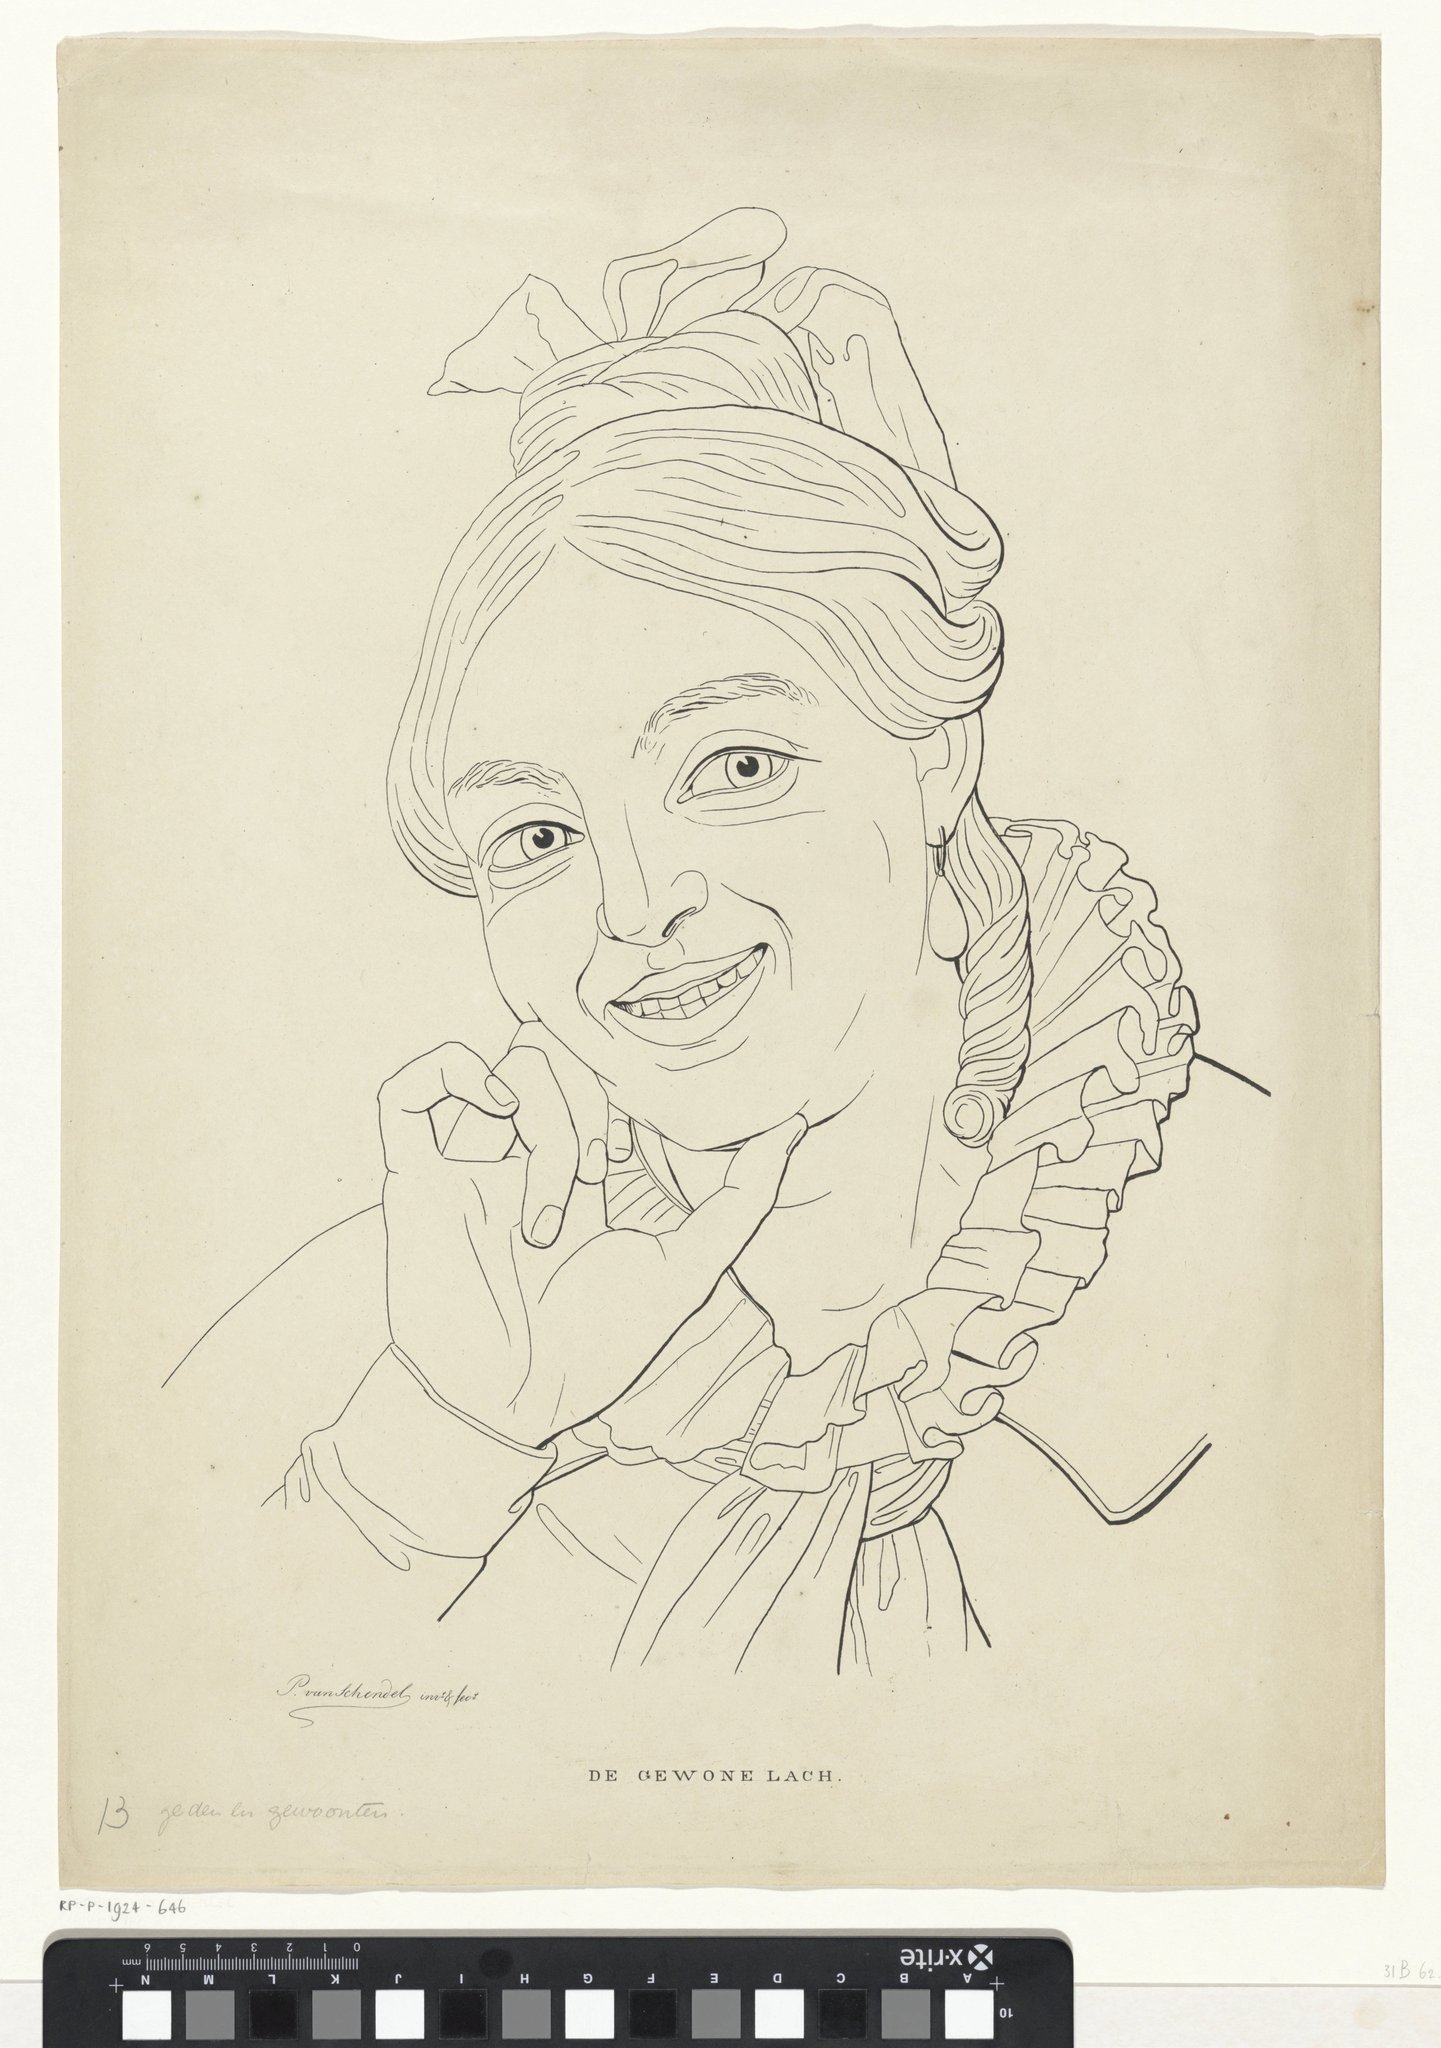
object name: print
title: De gewone lach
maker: petrus van schendel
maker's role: draughtsman, painter, print maker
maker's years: 1806-1870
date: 1834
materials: paper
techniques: etching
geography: rotterdam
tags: passions, emotions, affections, smiling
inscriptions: collector's mark: Lugt 2233, collector's mark: Lugt 2228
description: Prent was een proefdruk om potentiële afnemers te interesseren voor het werk: Schendel, Petrus van. De hartstogten, afgebeeld in 72 expressiehoofden, Rotterdam: Wed. van der Meer & Verbruggen, 1834